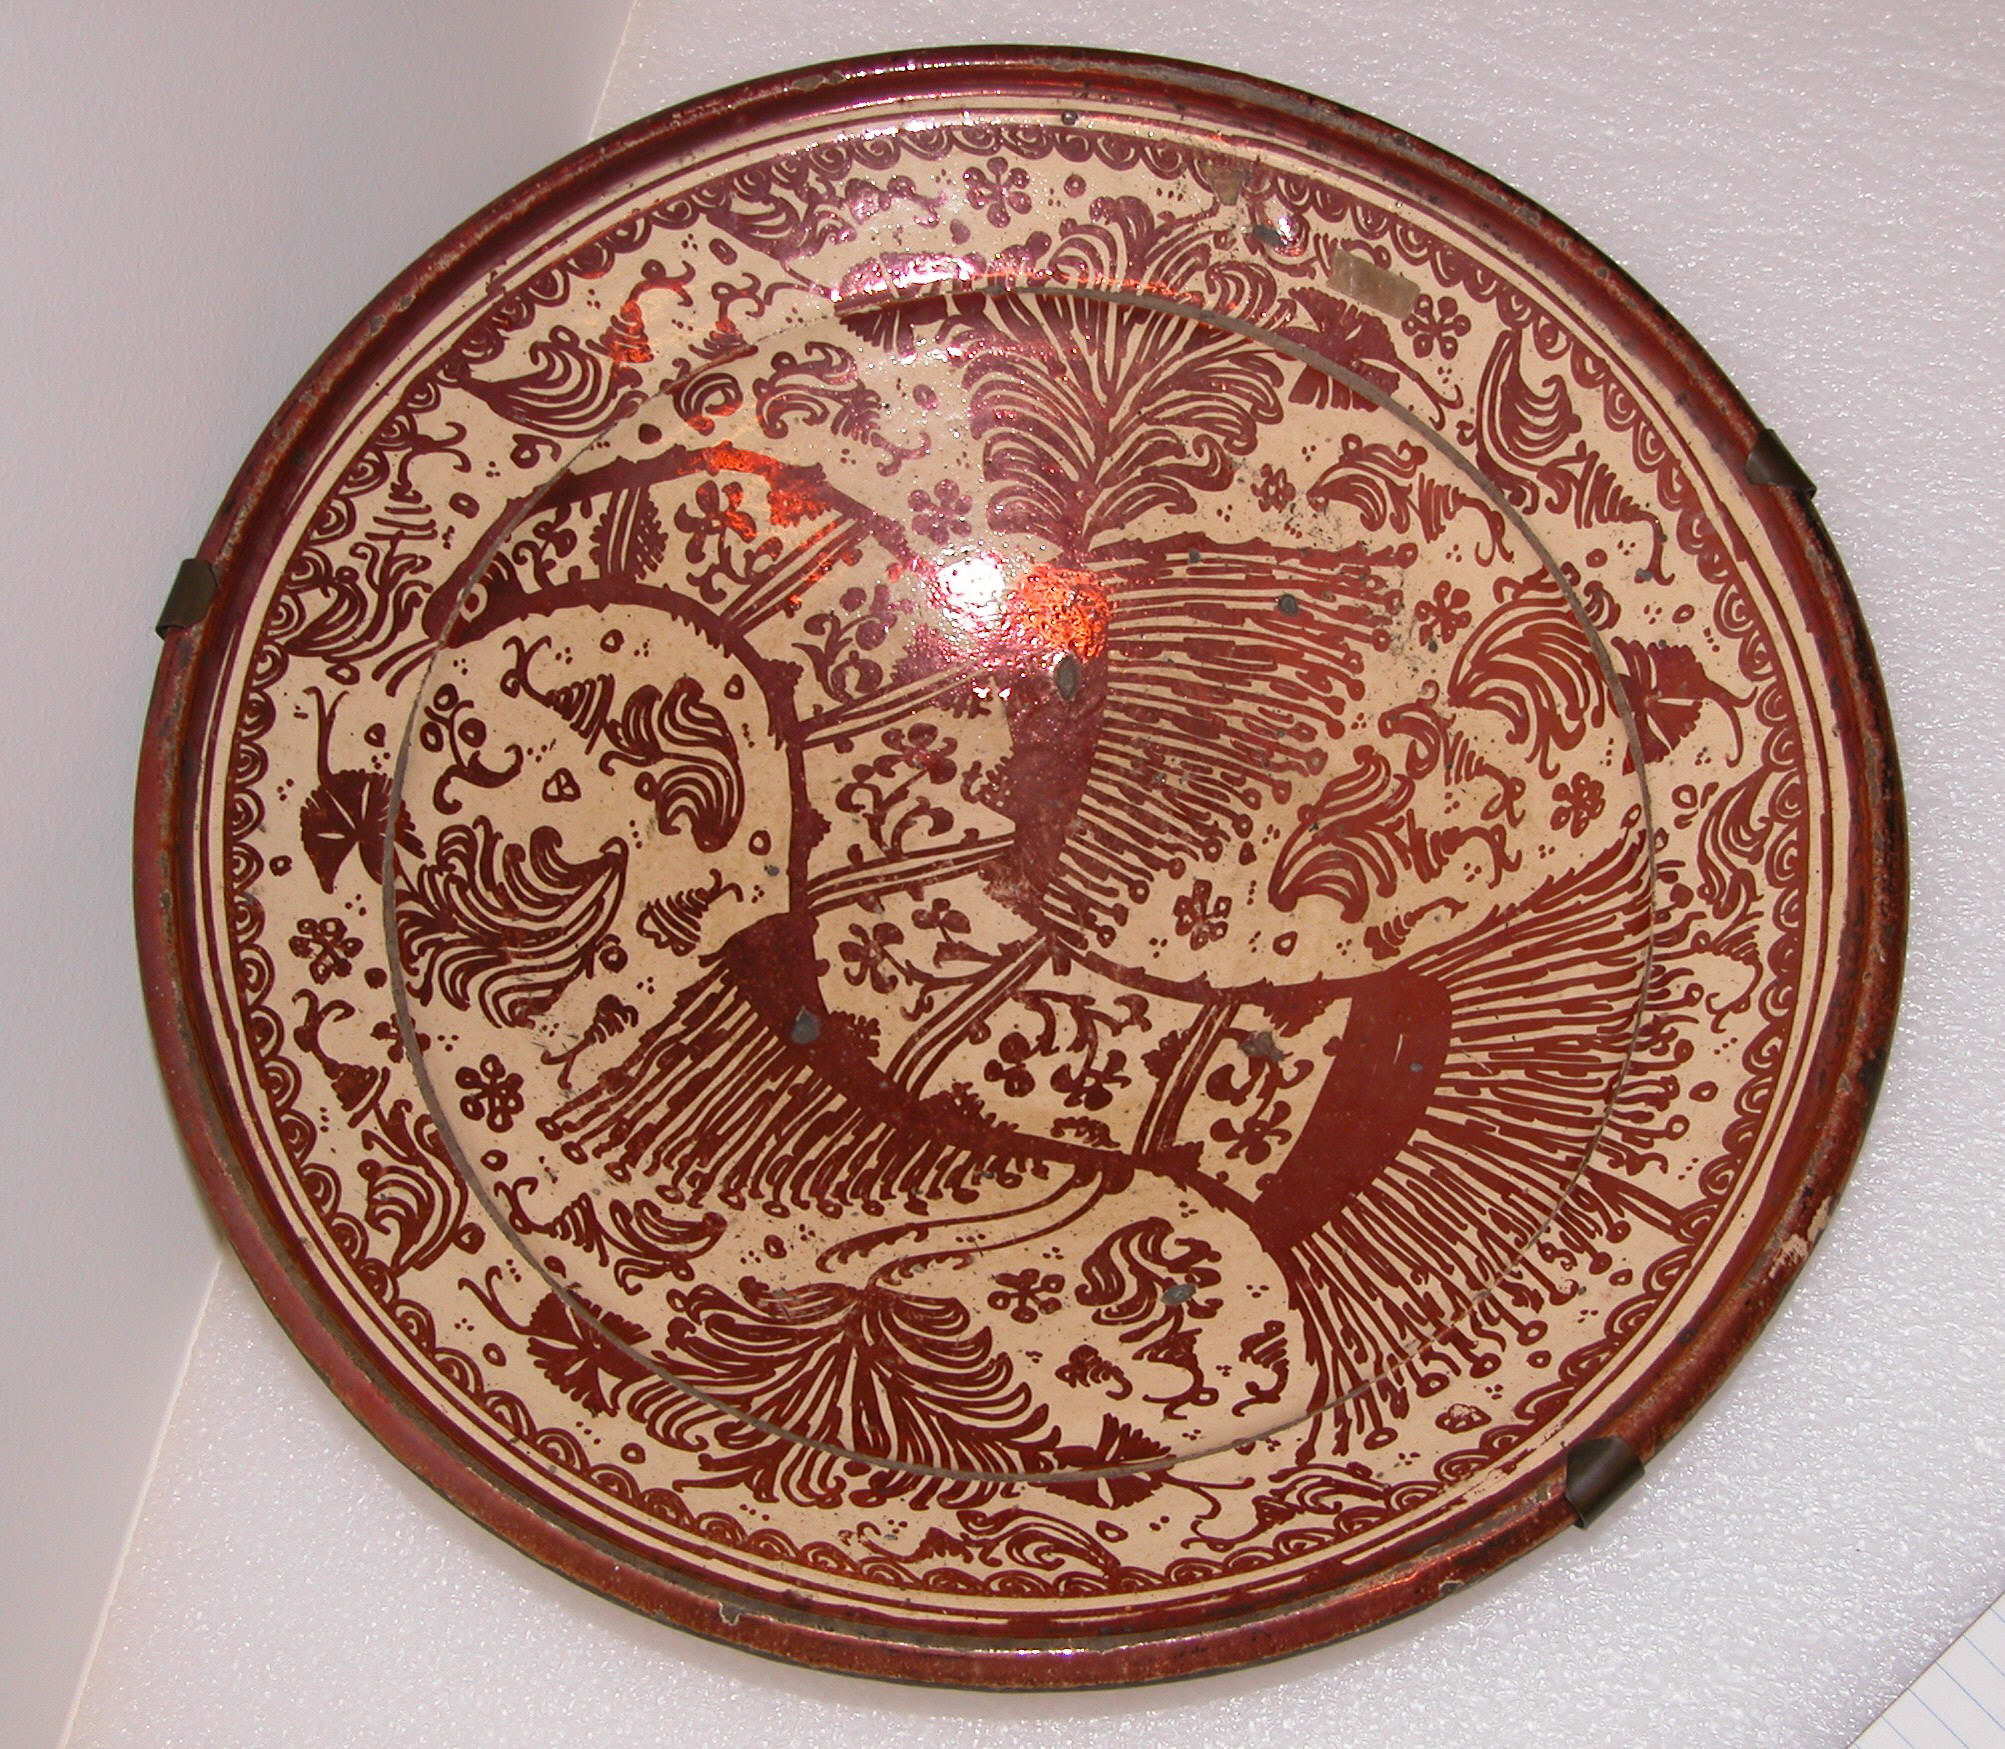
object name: bowl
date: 1700-1750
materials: earthenware, glaze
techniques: luster painting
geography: spain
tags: birds